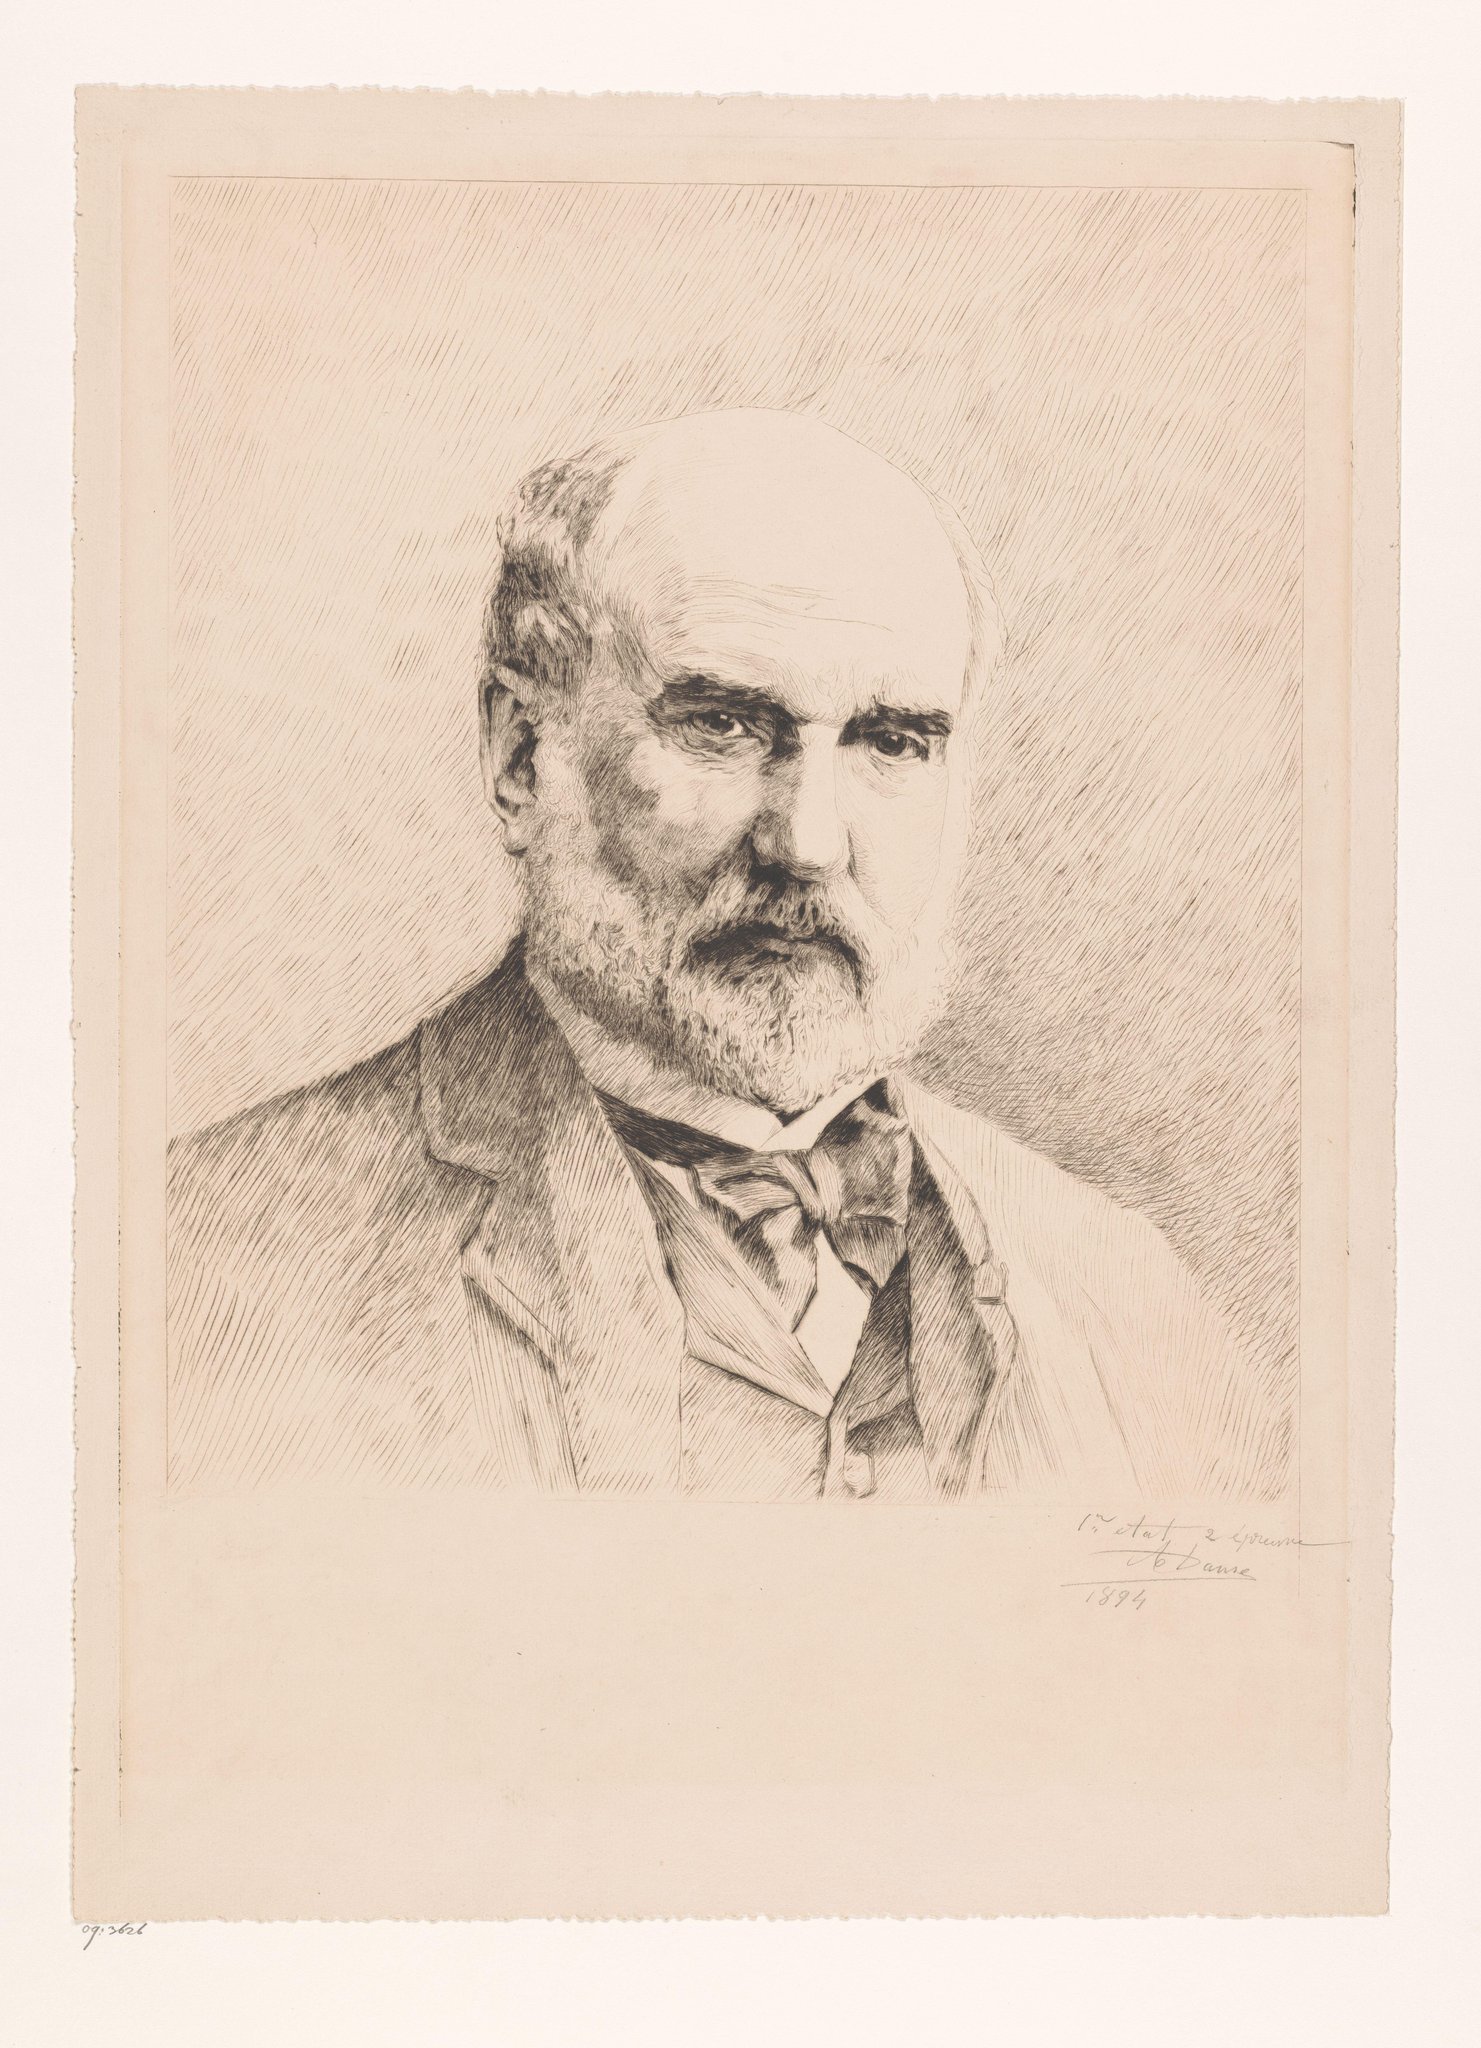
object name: print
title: Portret van Eudore Pirmez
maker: auguste danse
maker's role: print maker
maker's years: 1829-1929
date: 1894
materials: paper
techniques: drypoint, etching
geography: belgium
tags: historical persons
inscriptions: collector's mark: Lugt 2228, annotation: ‘1er etat 2 épreuve’